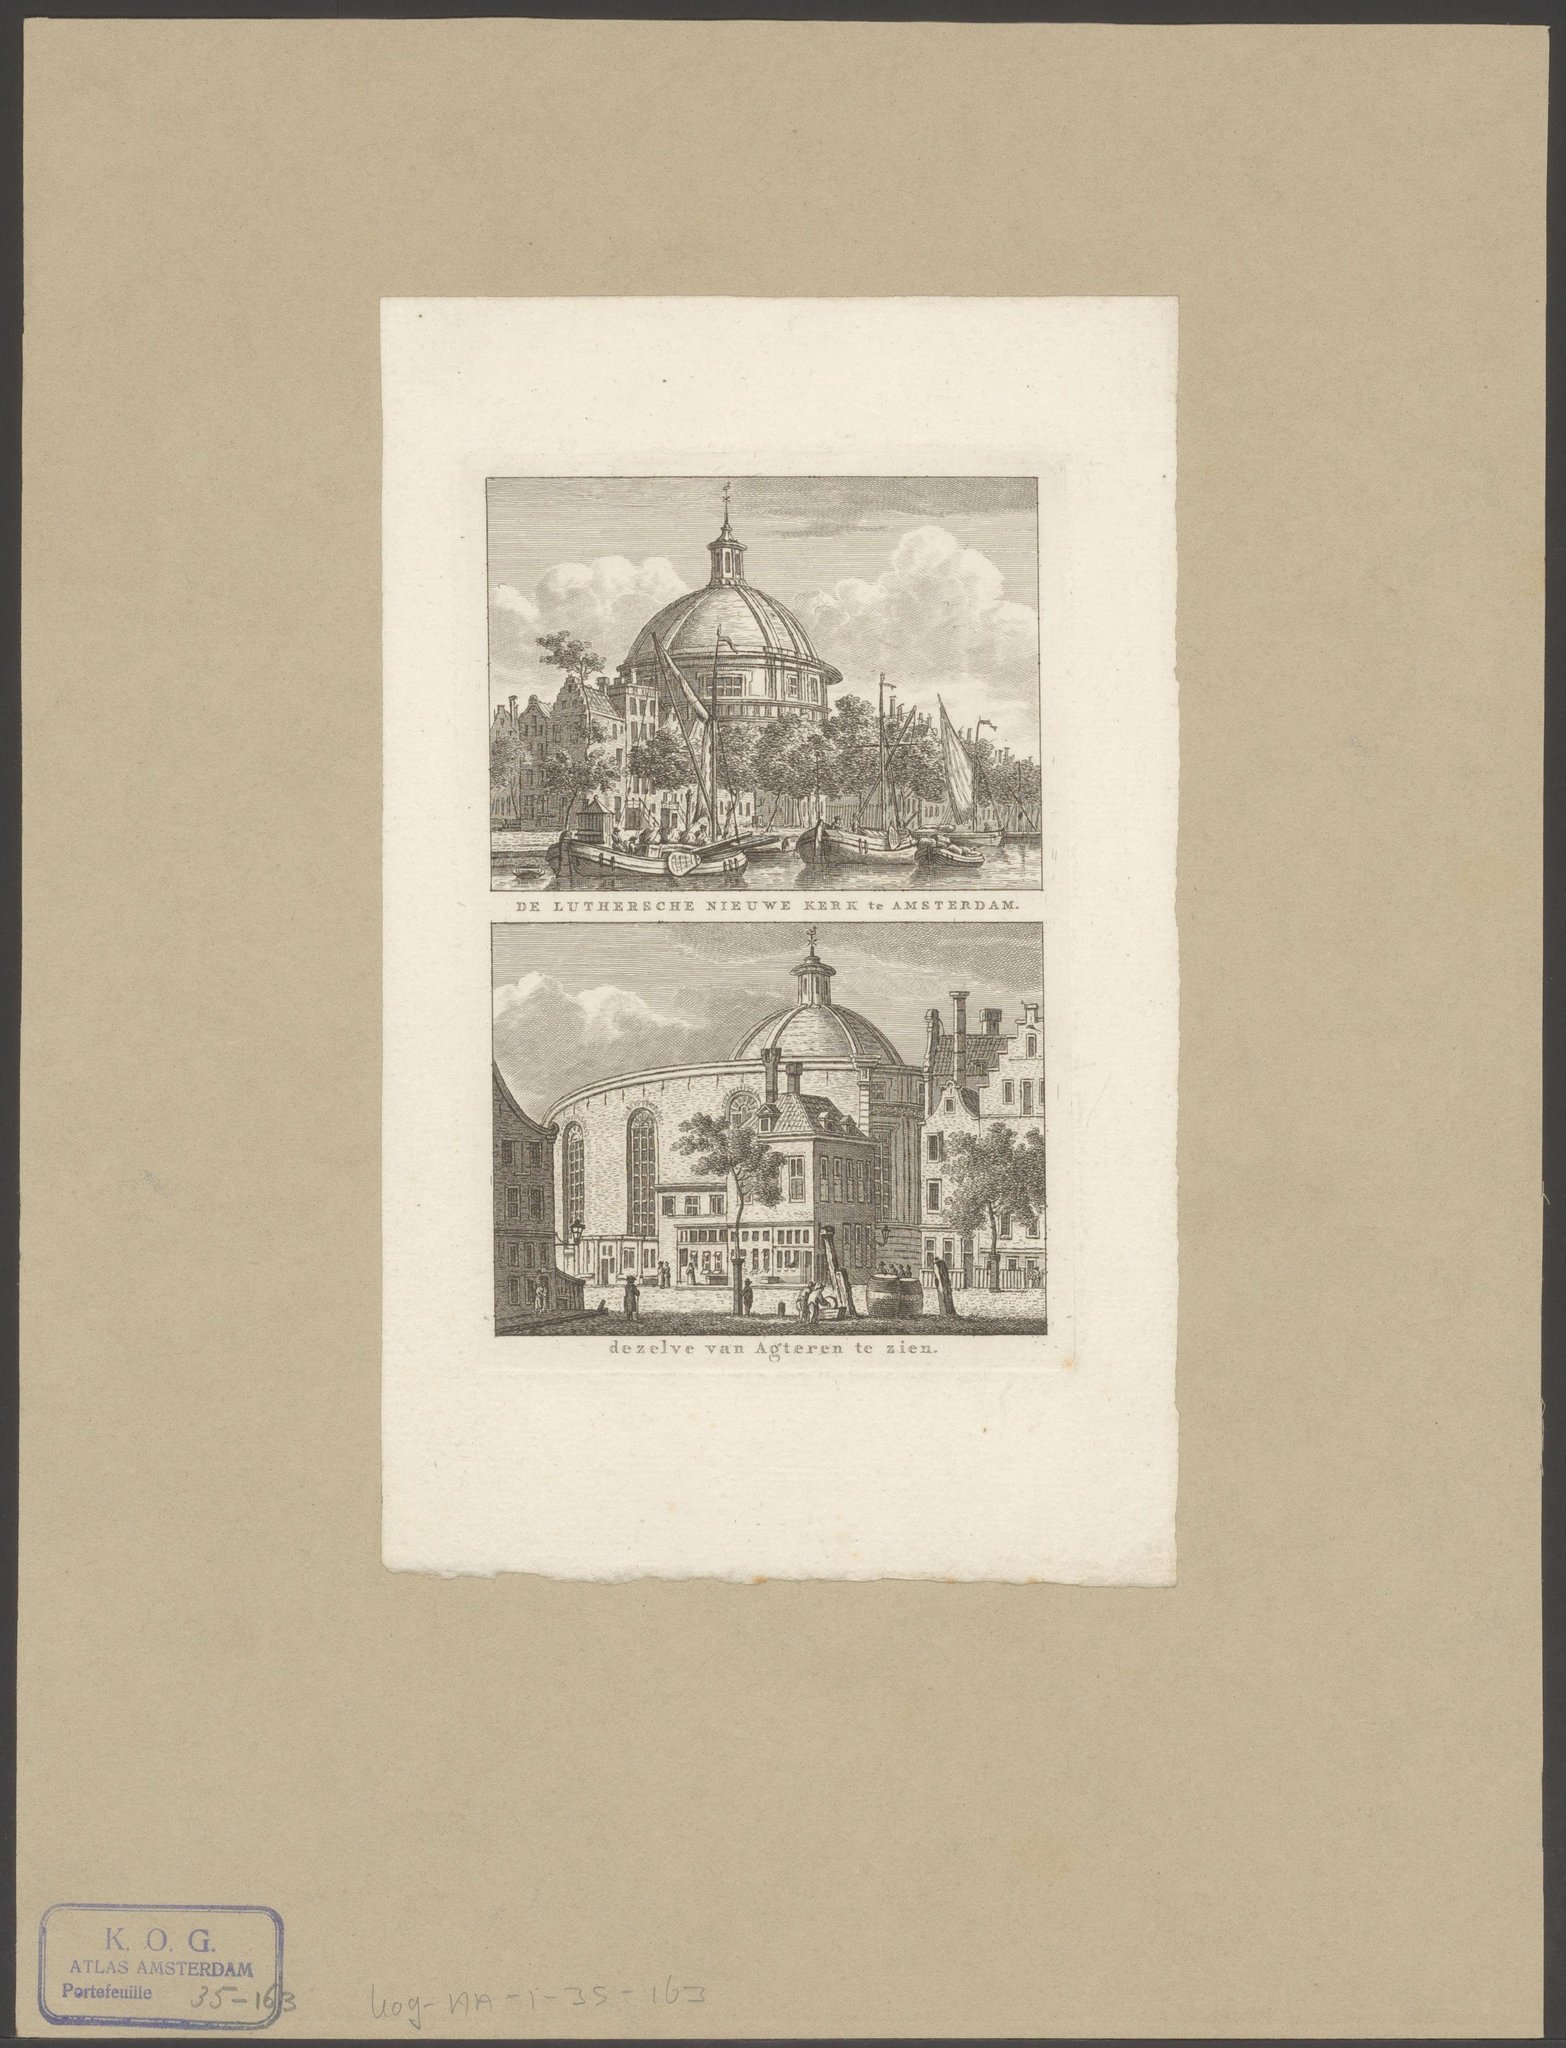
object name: print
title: De Luthersche Nieuwe Kerk te Amsterdam / dezelve van Agteren te zien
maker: carel frederik bendorp (i)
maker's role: print maker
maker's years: 1736-1814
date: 1786-1792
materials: paper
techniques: etching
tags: canal, church (exterior)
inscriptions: collector's mark: Lugt 1641b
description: Prent mogelijk uit: Vaderlandsche gezichten, of afbeeldingen van den tegenwoordigen staat der Vereenigde Nederlanden (…). Amsterdam: Hendrik Gartman, Willem Vermandel en Jan Willem Smit, 1786-1792. Uitgegeven in afleveringen met ieder een eigen bifolium en inhoudsopgave. Alle prenten in deze publicatie zijn gegraveerd door Carel Frederik Bendorp (I) en, in de meeste gevallen, gebaseerd op tekeningen van Jan Bulthuis.